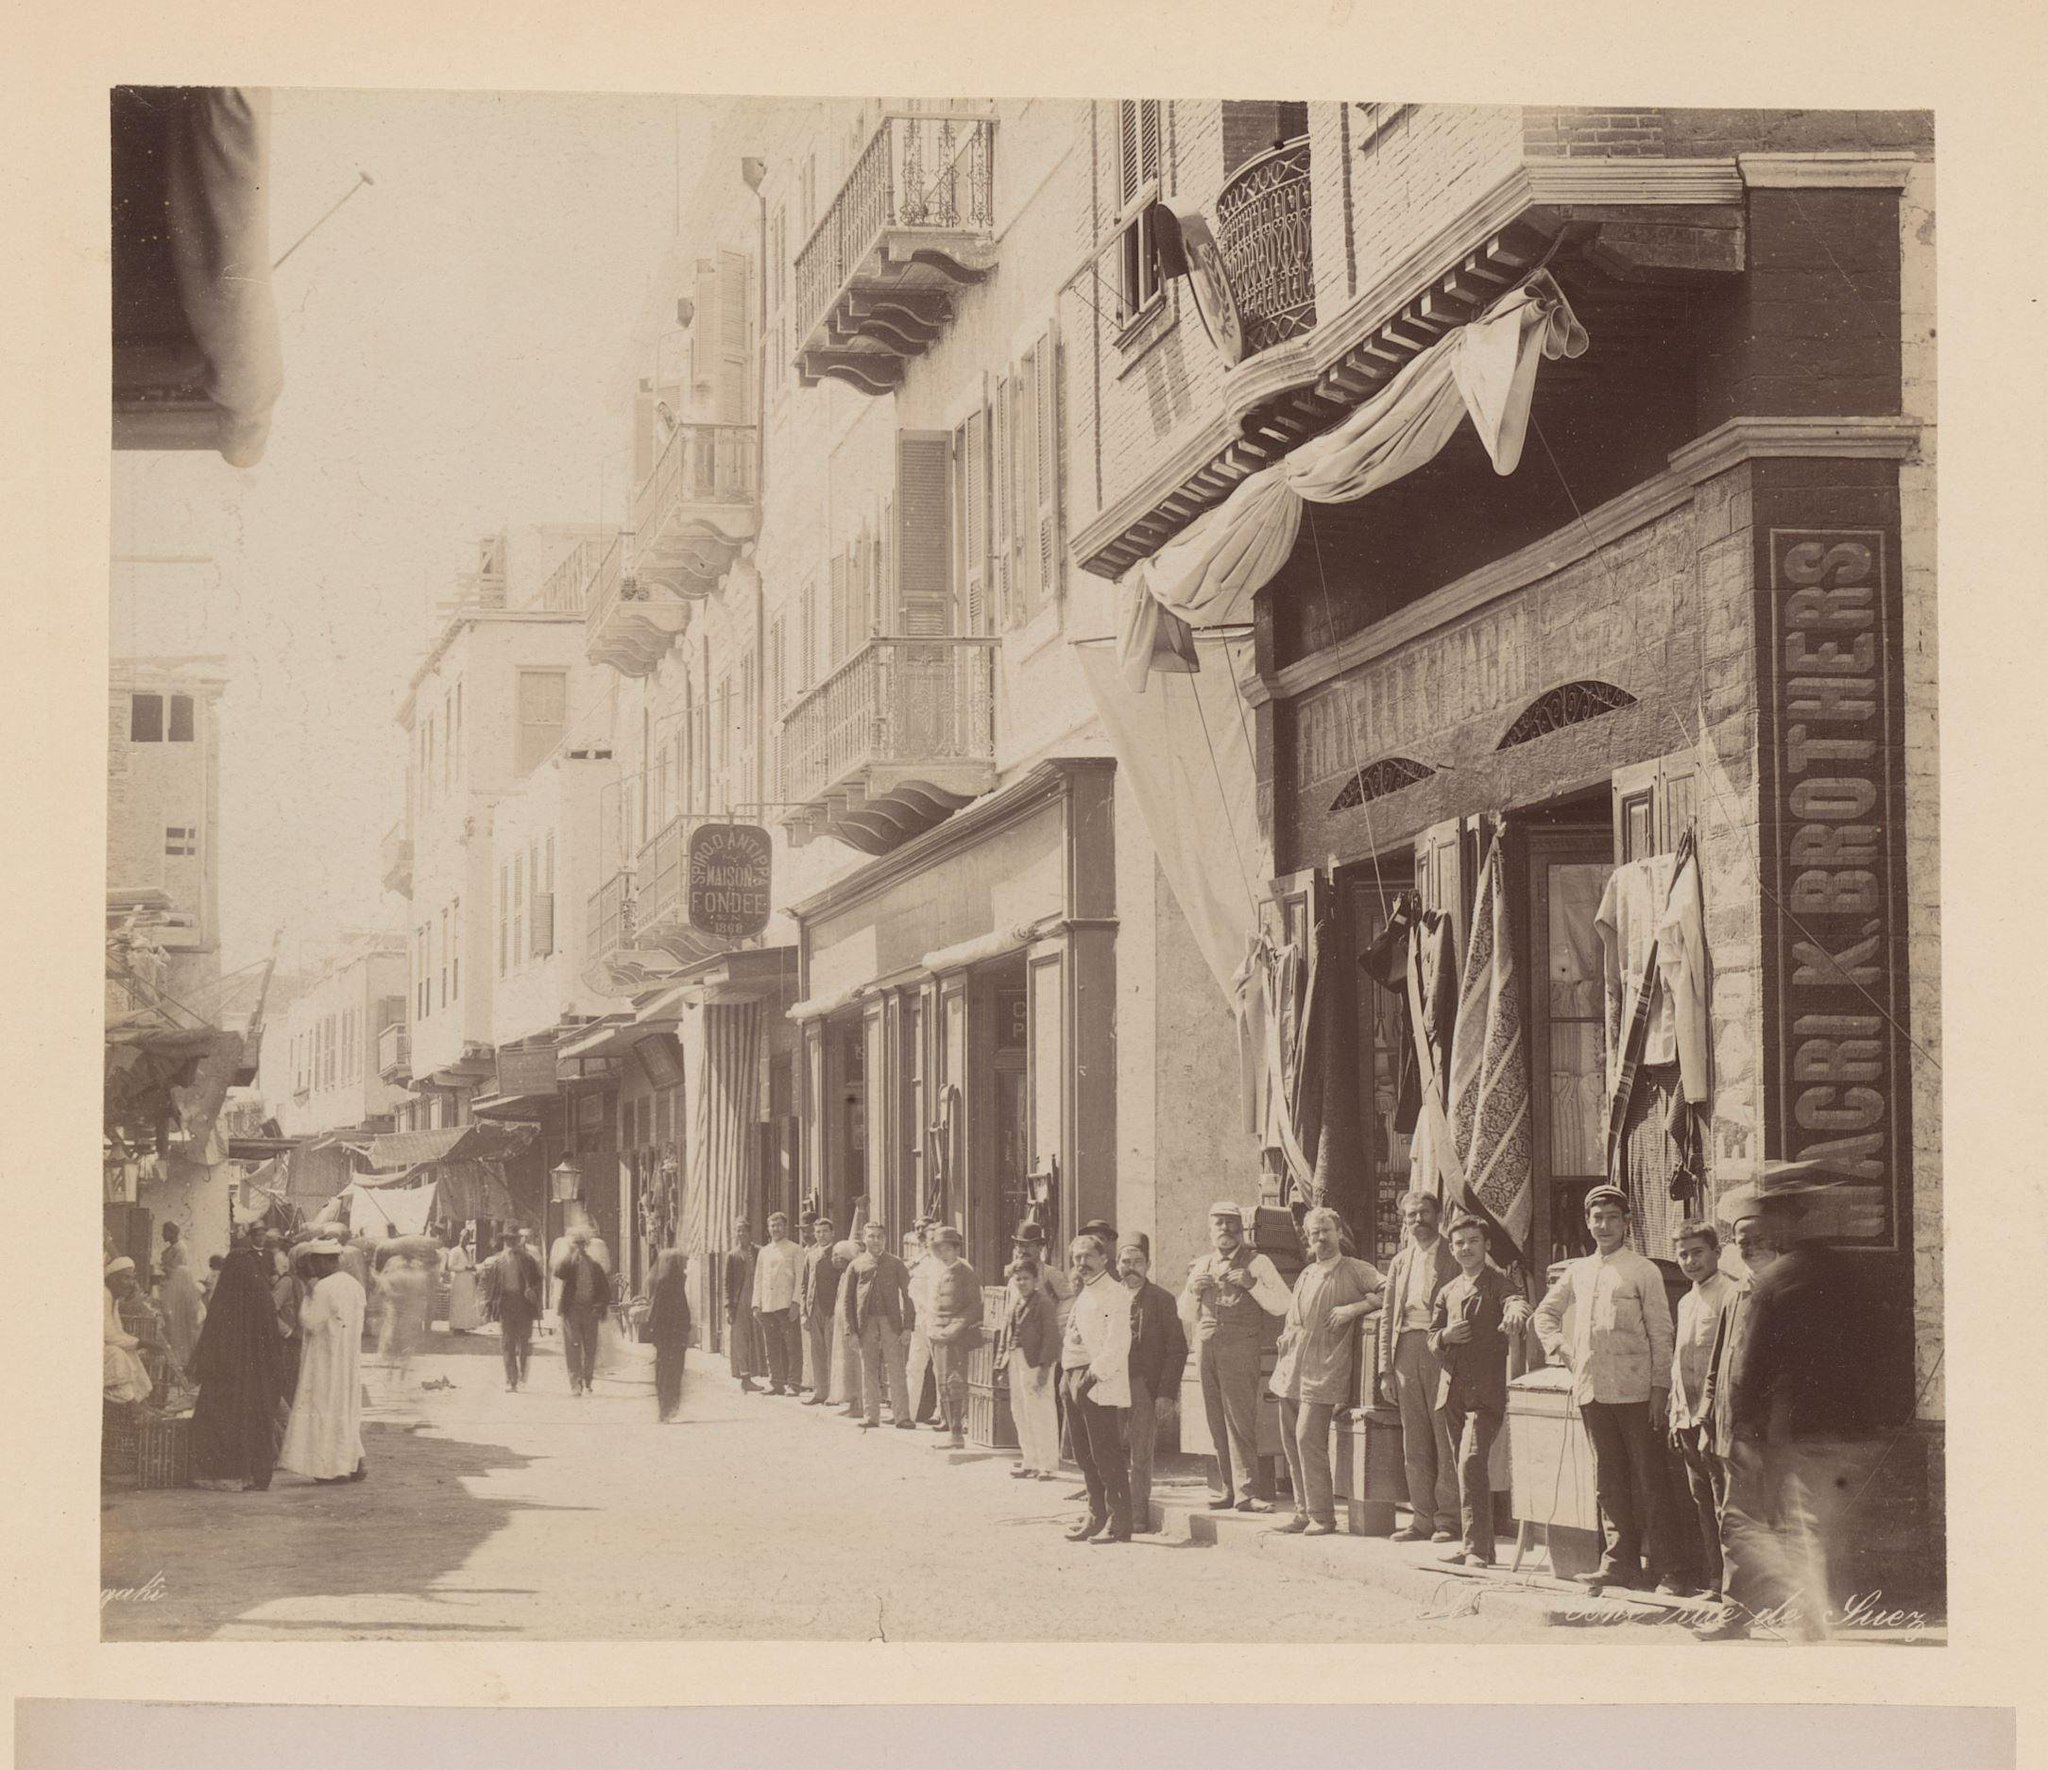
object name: album leaf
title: Gezicht op een straat in Suez, Egypte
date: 1890-1900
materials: cardboard, photographic support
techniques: albumen print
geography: suez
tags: adult man (+ more than eight persons), street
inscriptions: name: ‘Zangaki’, inscription: ‘No.[...], Une rue de Suez’